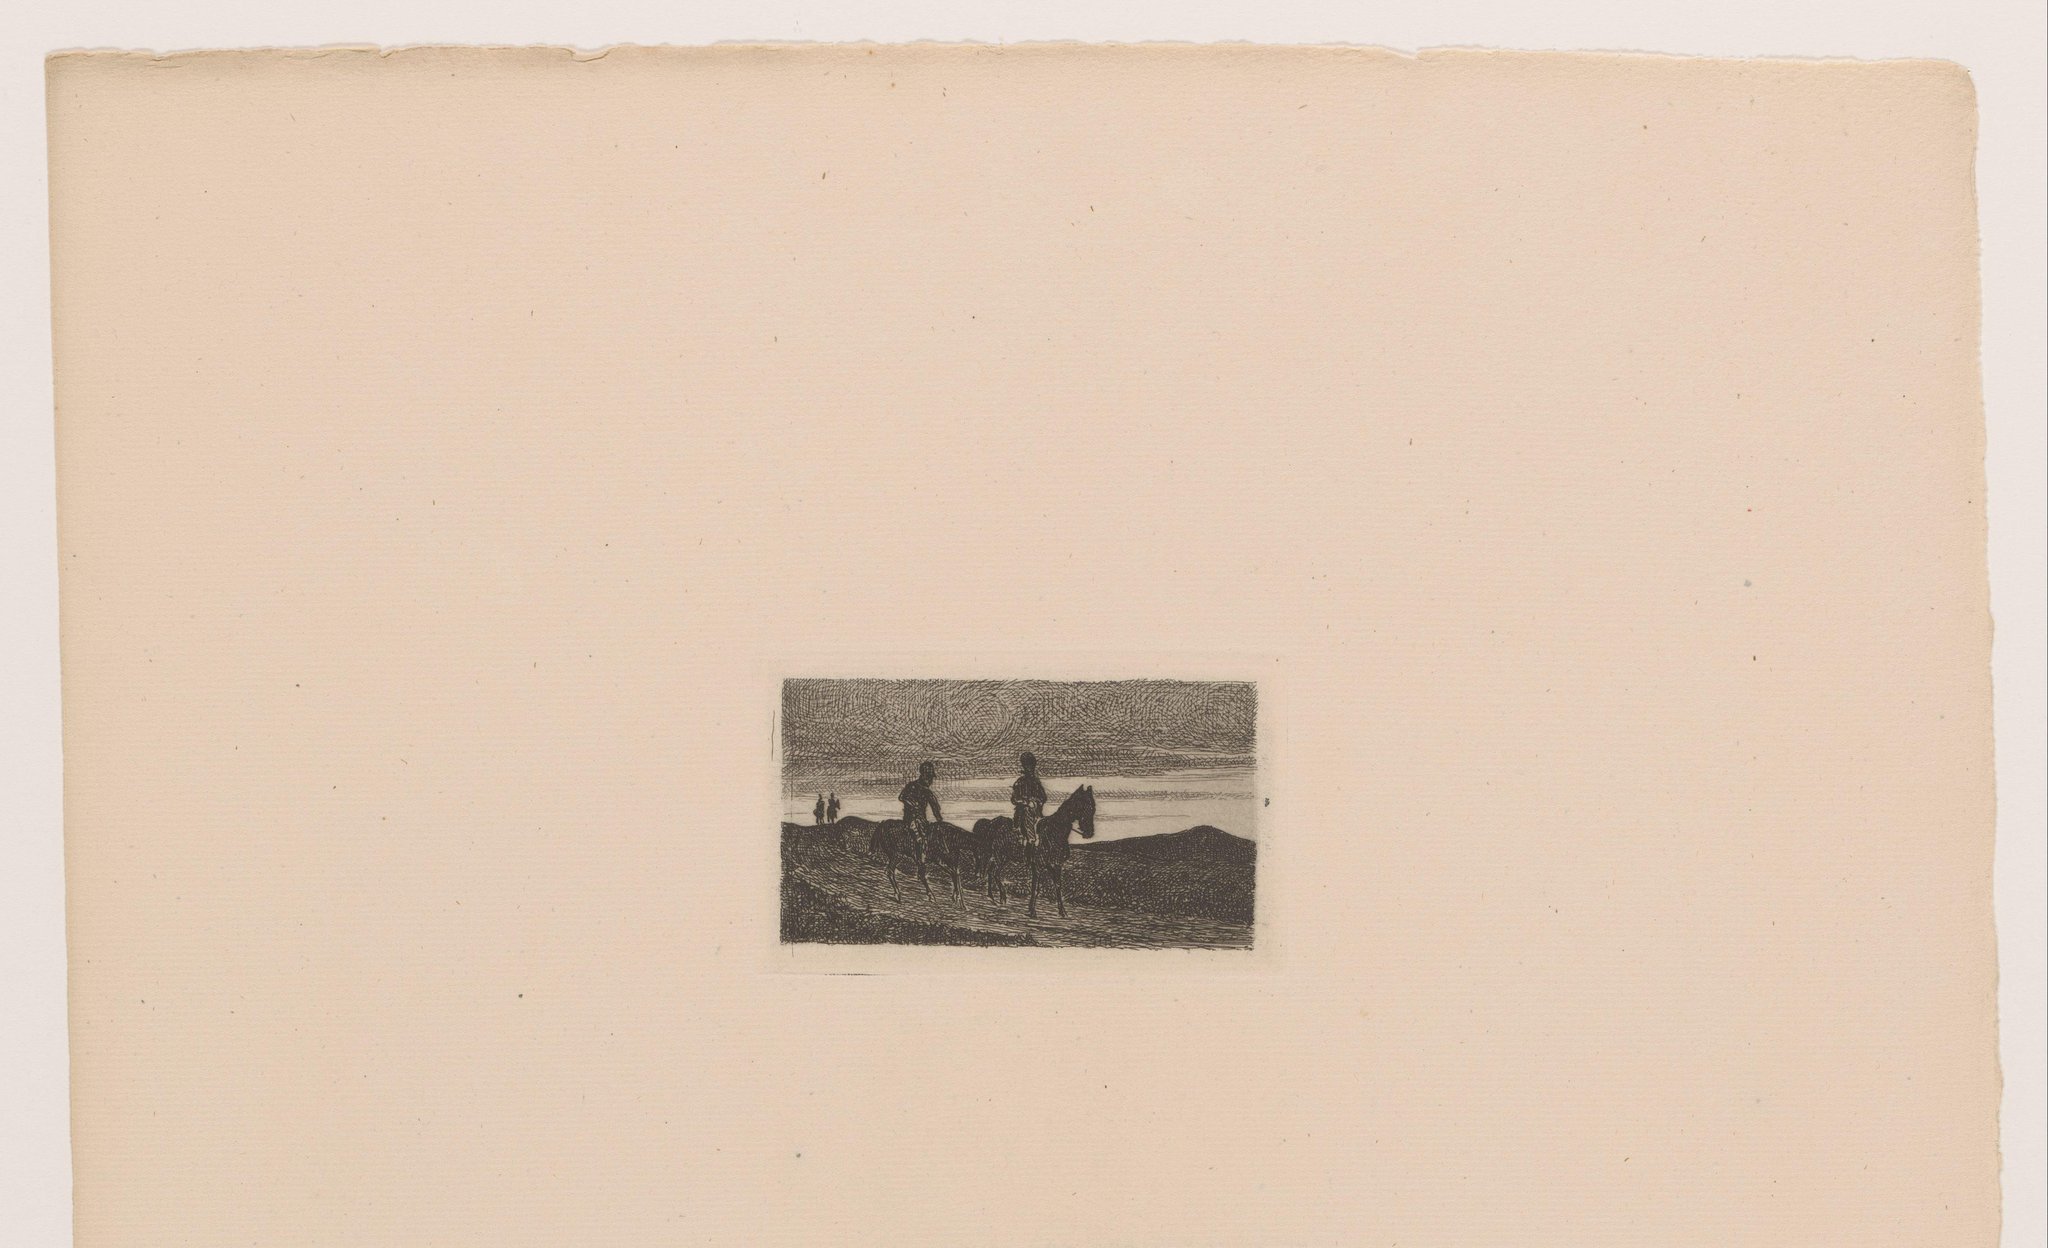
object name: print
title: Cahier d'études eau-fortes originales et inédites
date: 1875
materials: paper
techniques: drypoint, etching, intaglio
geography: brussels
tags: riding a horse, ass, or mule; rider, horseman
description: Prent uit: Rops, Félicien (red.), Cahier d'études eaux-fortes originales et inédites. Brussel: Felix Callewaert père, 1875.